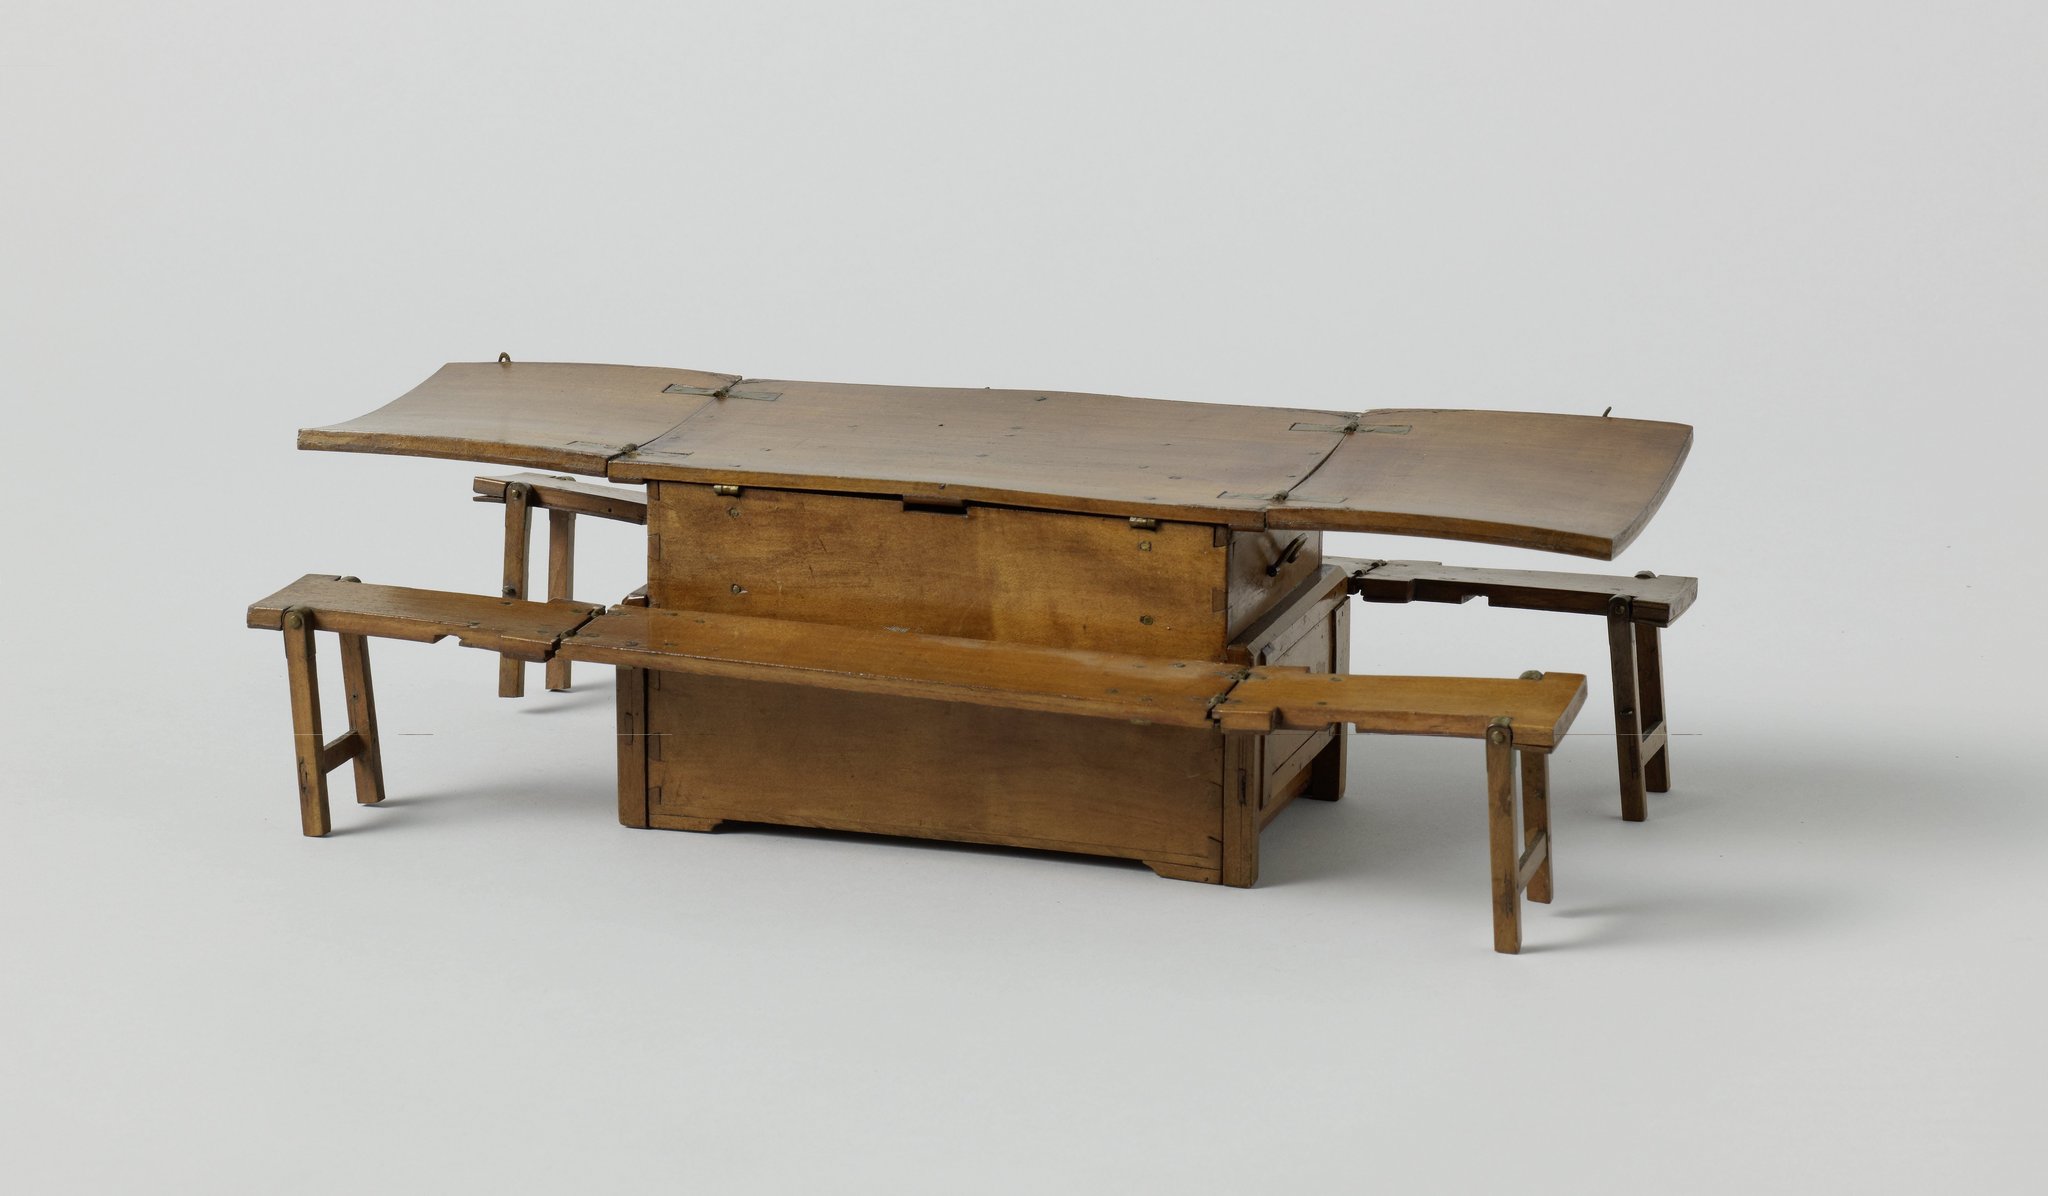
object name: presentation model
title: Model of a Mess Table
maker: monogrammist dw (modelmaker)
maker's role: model maker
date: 1817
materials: brass, wood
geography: zeeland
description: Model van een opvouwbare bakstafel, erg kromgetrokken. Het lichaam is een kist met vier compartimenten onderin en twee lades boven. Het deksel heeft twee uitklapbare stukken die, ondersteund door uitschuifbare planken, een groot tafelblad vormen. Tegen de lange zijden zijn uitklapbare banken aangebracht, met extra steunen die uit de korte zijden schuiven.